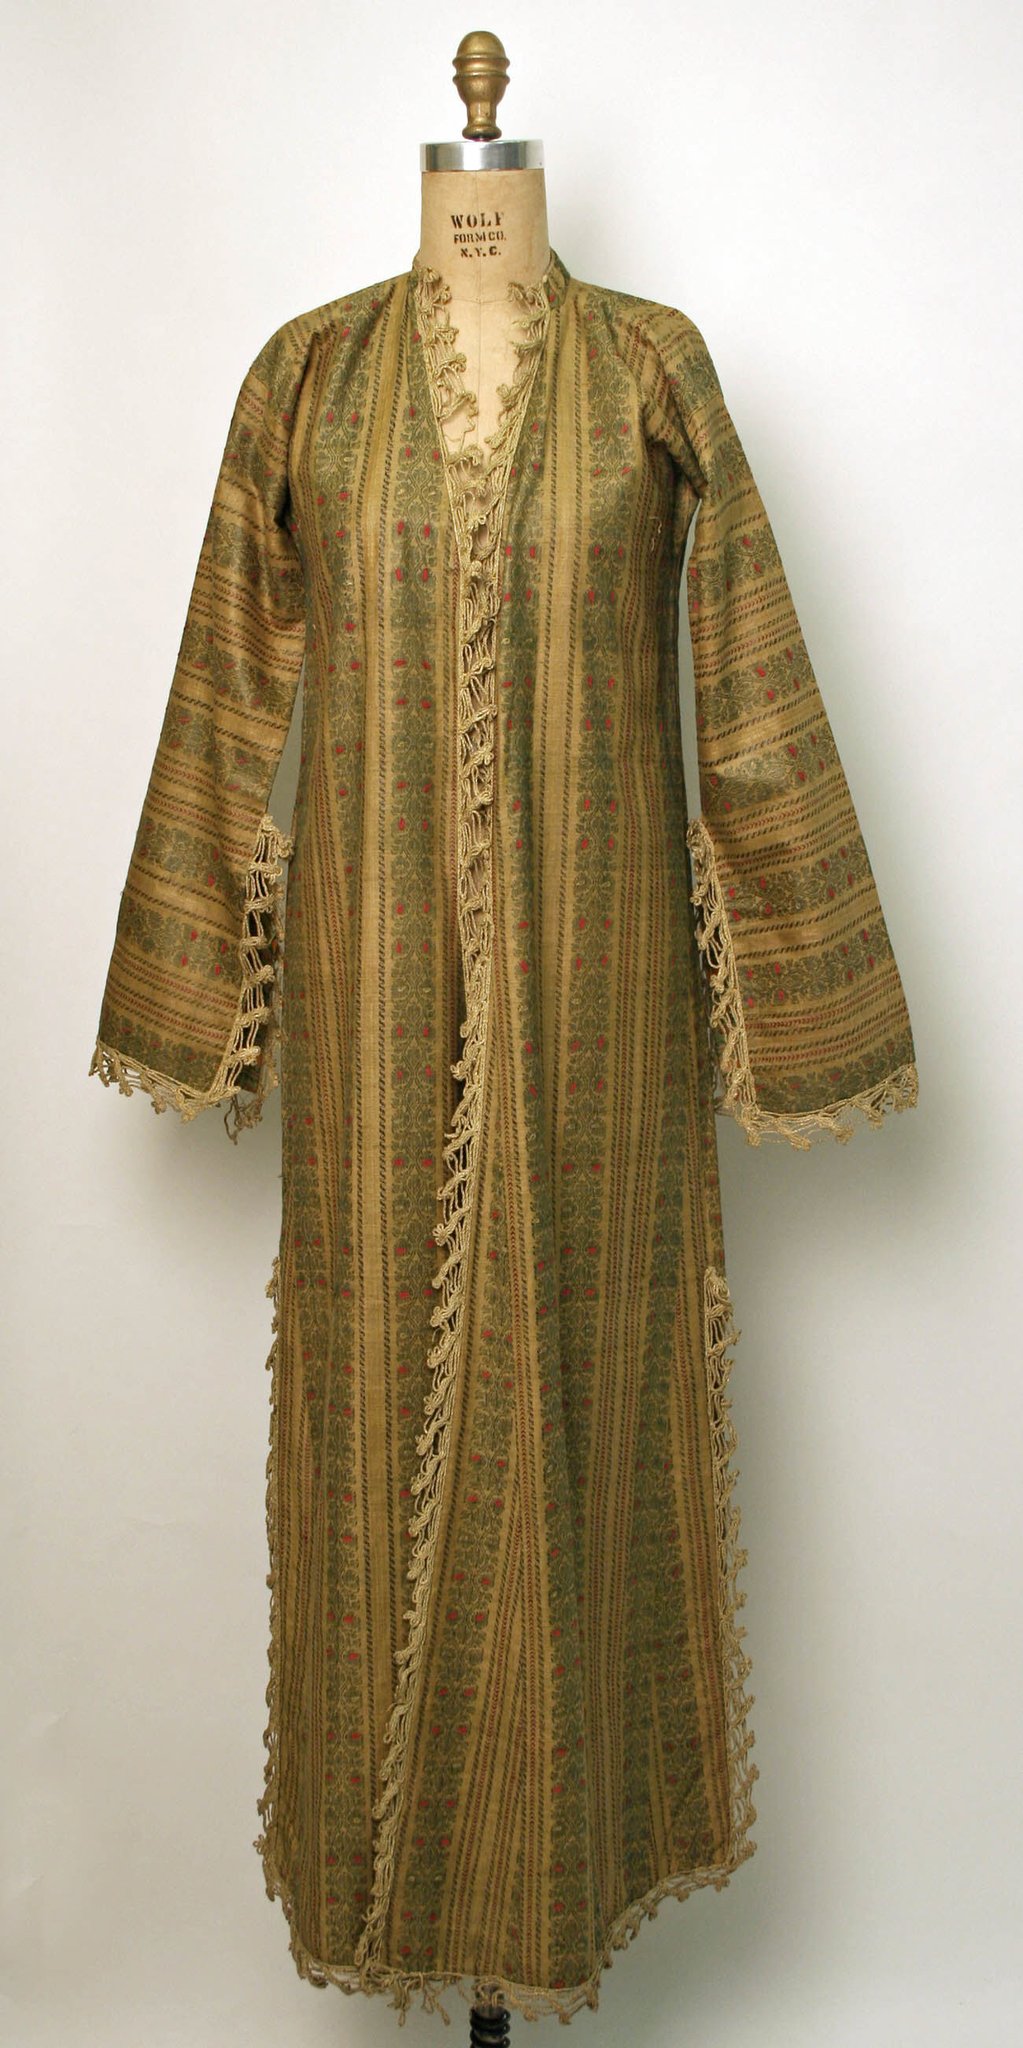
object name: robe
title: Uçetek Entari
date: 1801-1900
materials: cotton, metal thread, silk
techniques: embroidery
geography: turkey